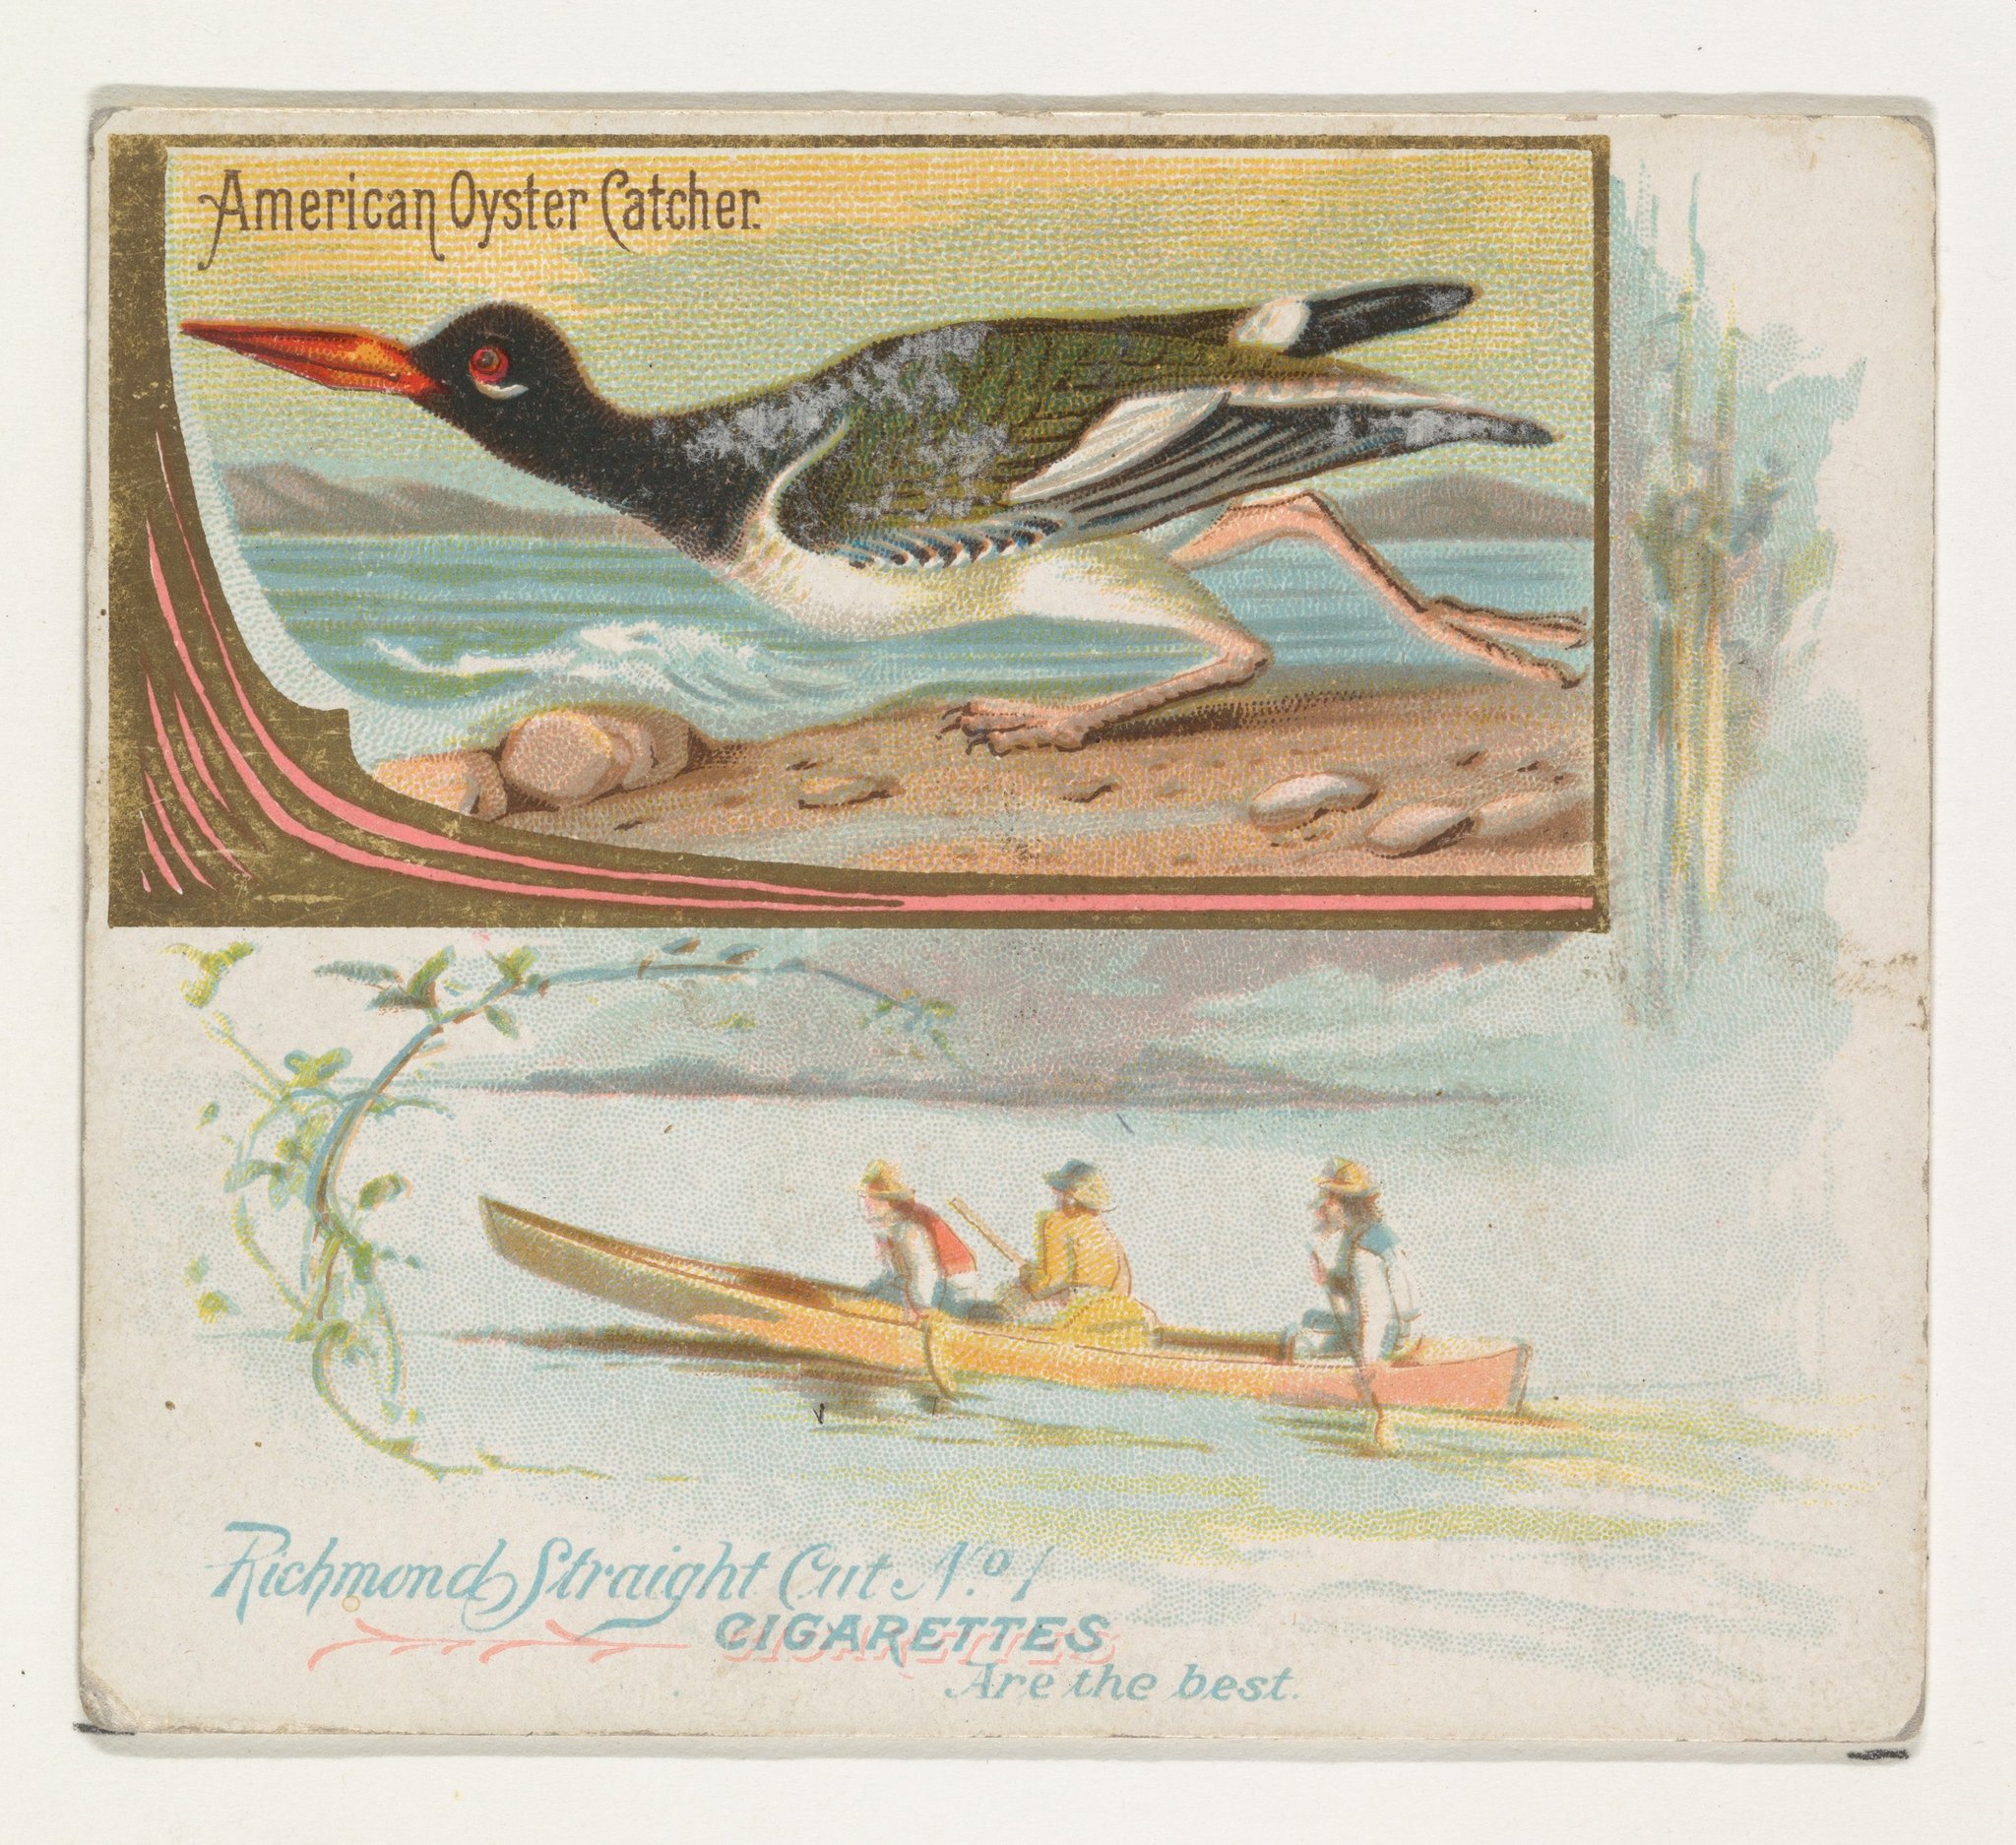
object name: print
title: American Oyster Catcher, from the Game Birds series (N40) for Allen & Ginter Cigarettes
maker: allen & ginter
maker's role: publisher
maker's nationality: american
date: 1888-1890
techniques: color lithograph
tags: birds,boats